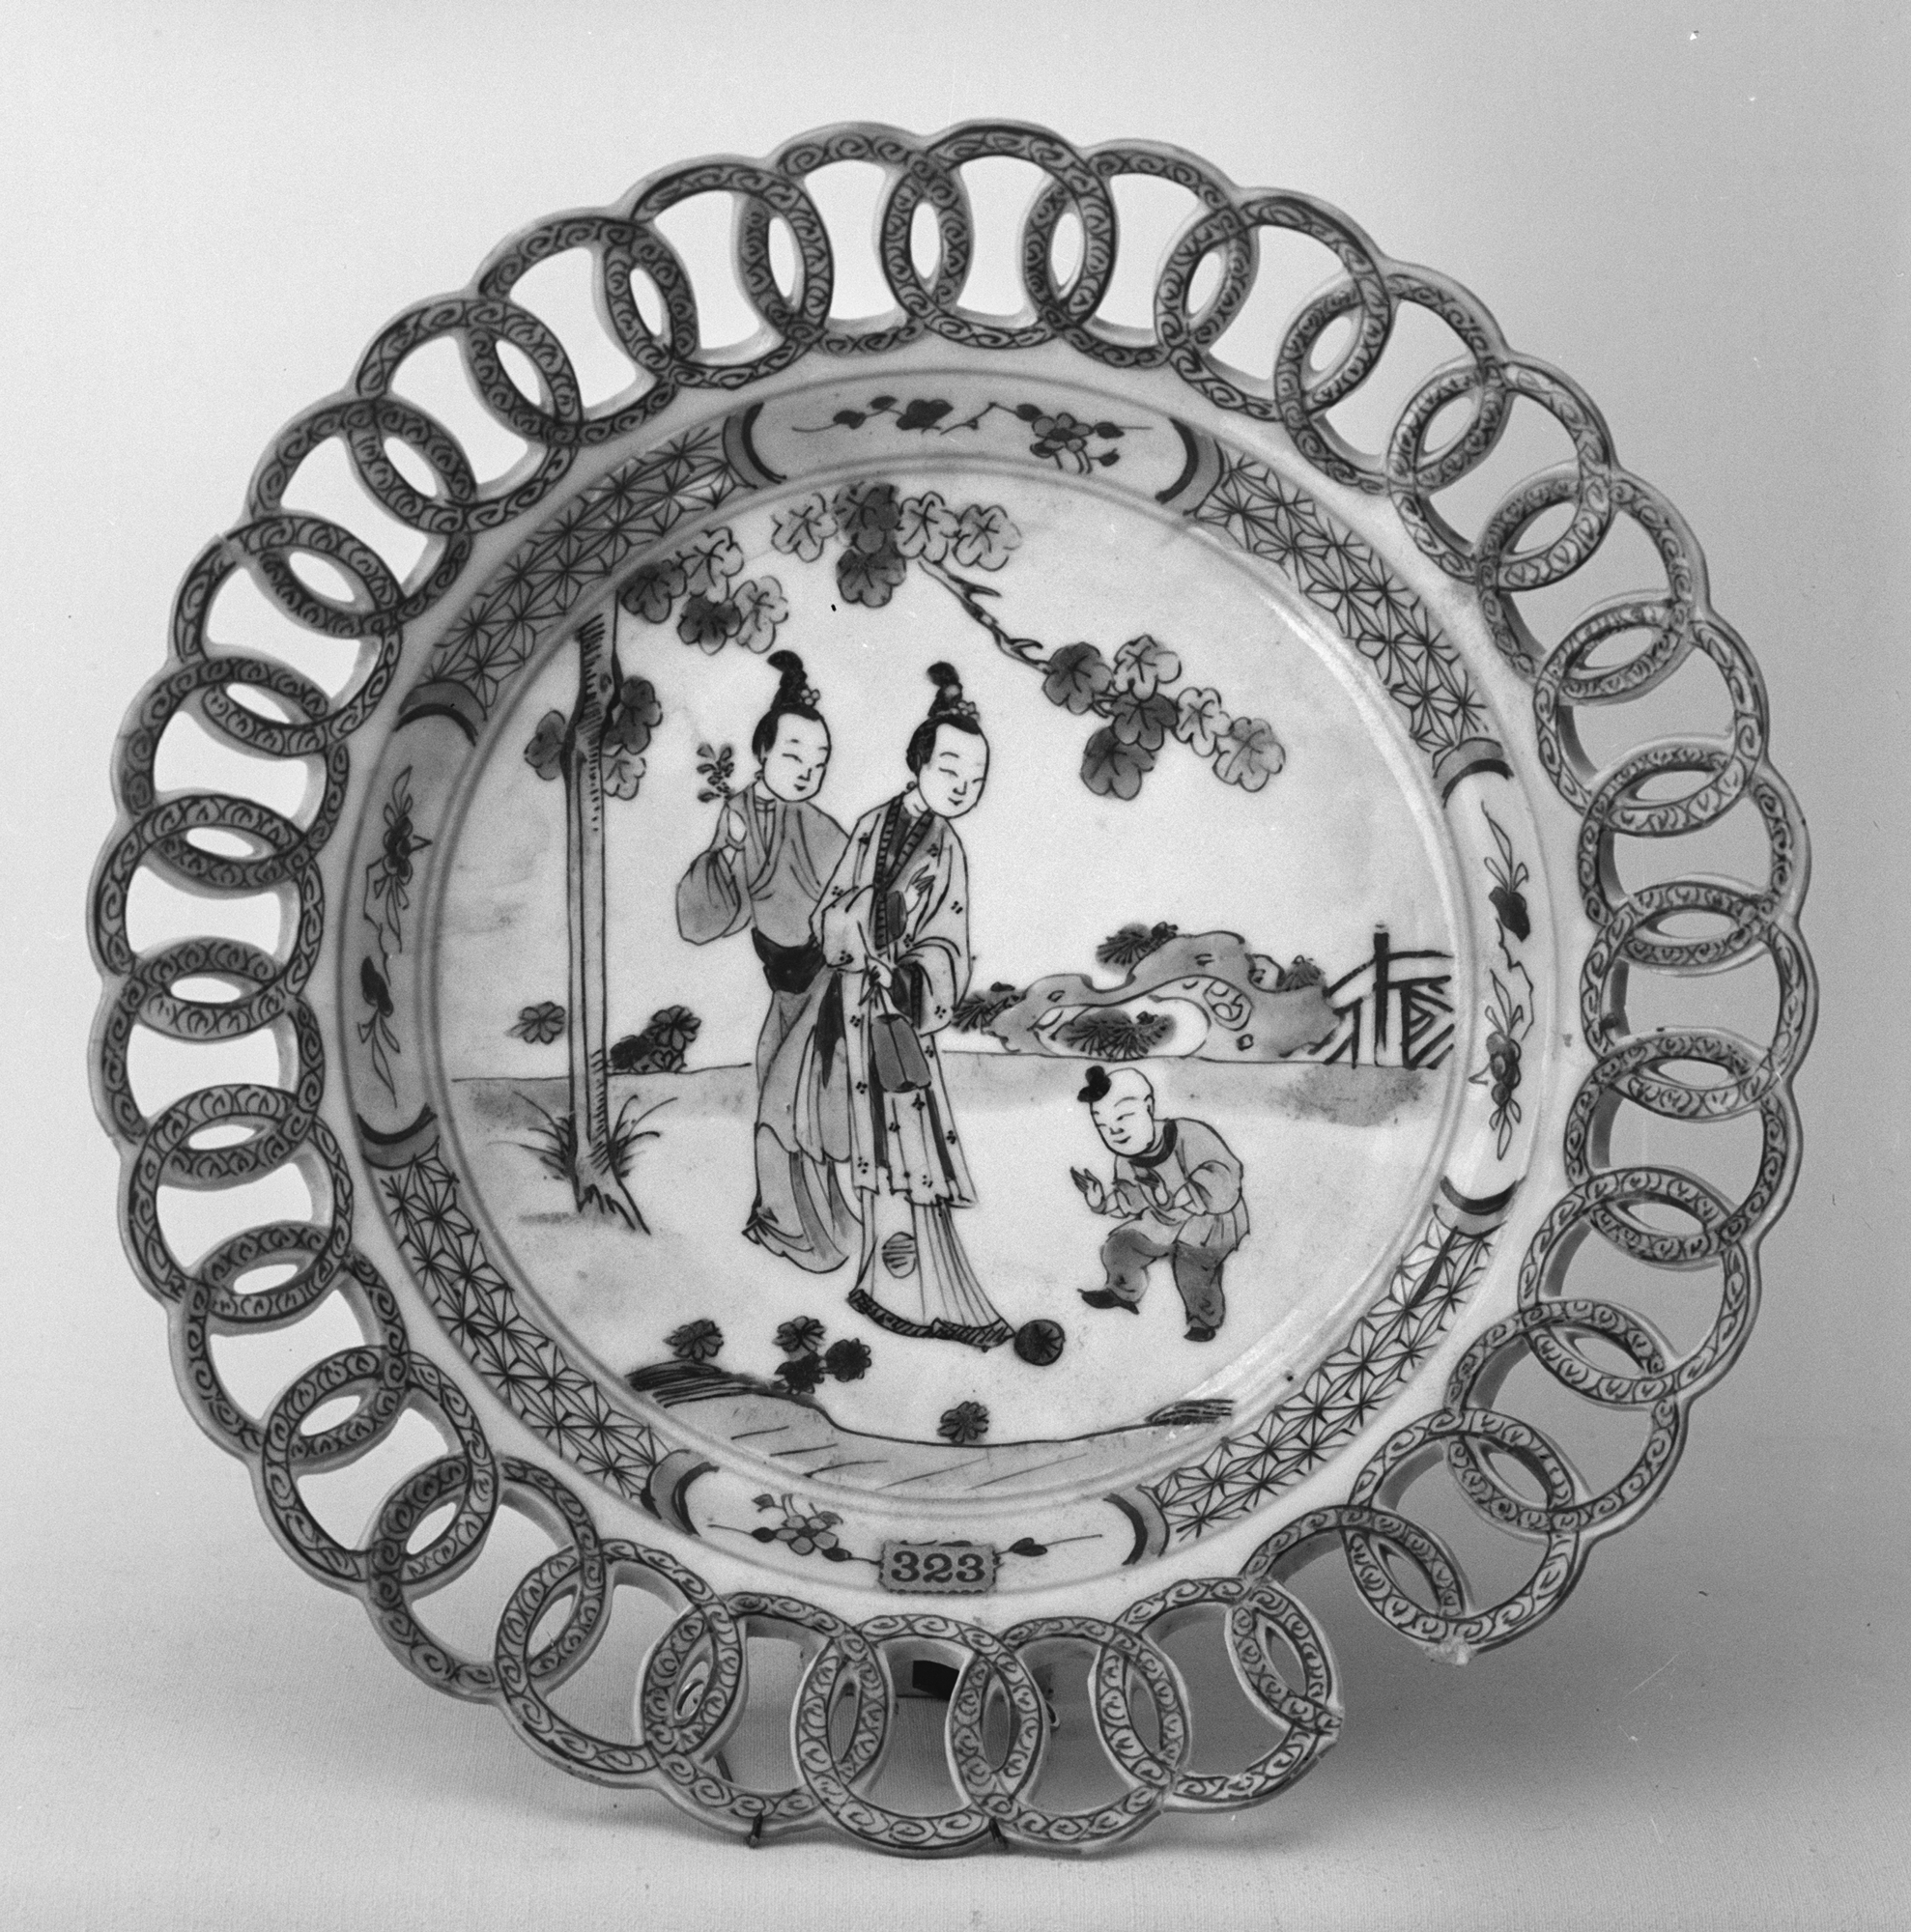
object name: dish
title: Dish with ladies and boy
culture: chinese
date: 1667-1733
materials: enamel, porcelain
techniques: overglaze, painting, polychrome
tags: boys,women